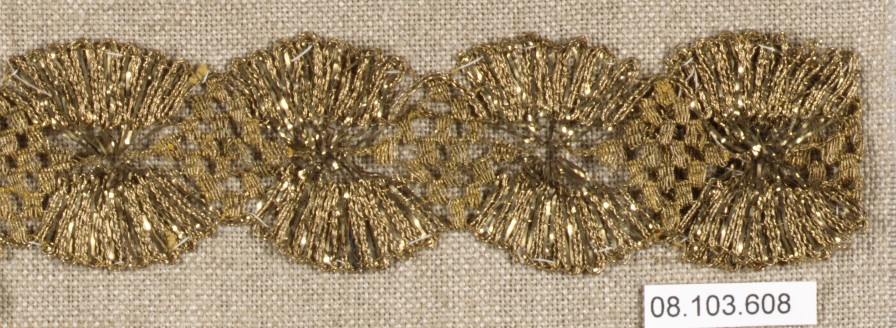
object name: galloon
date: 1701-1800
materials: metal thread